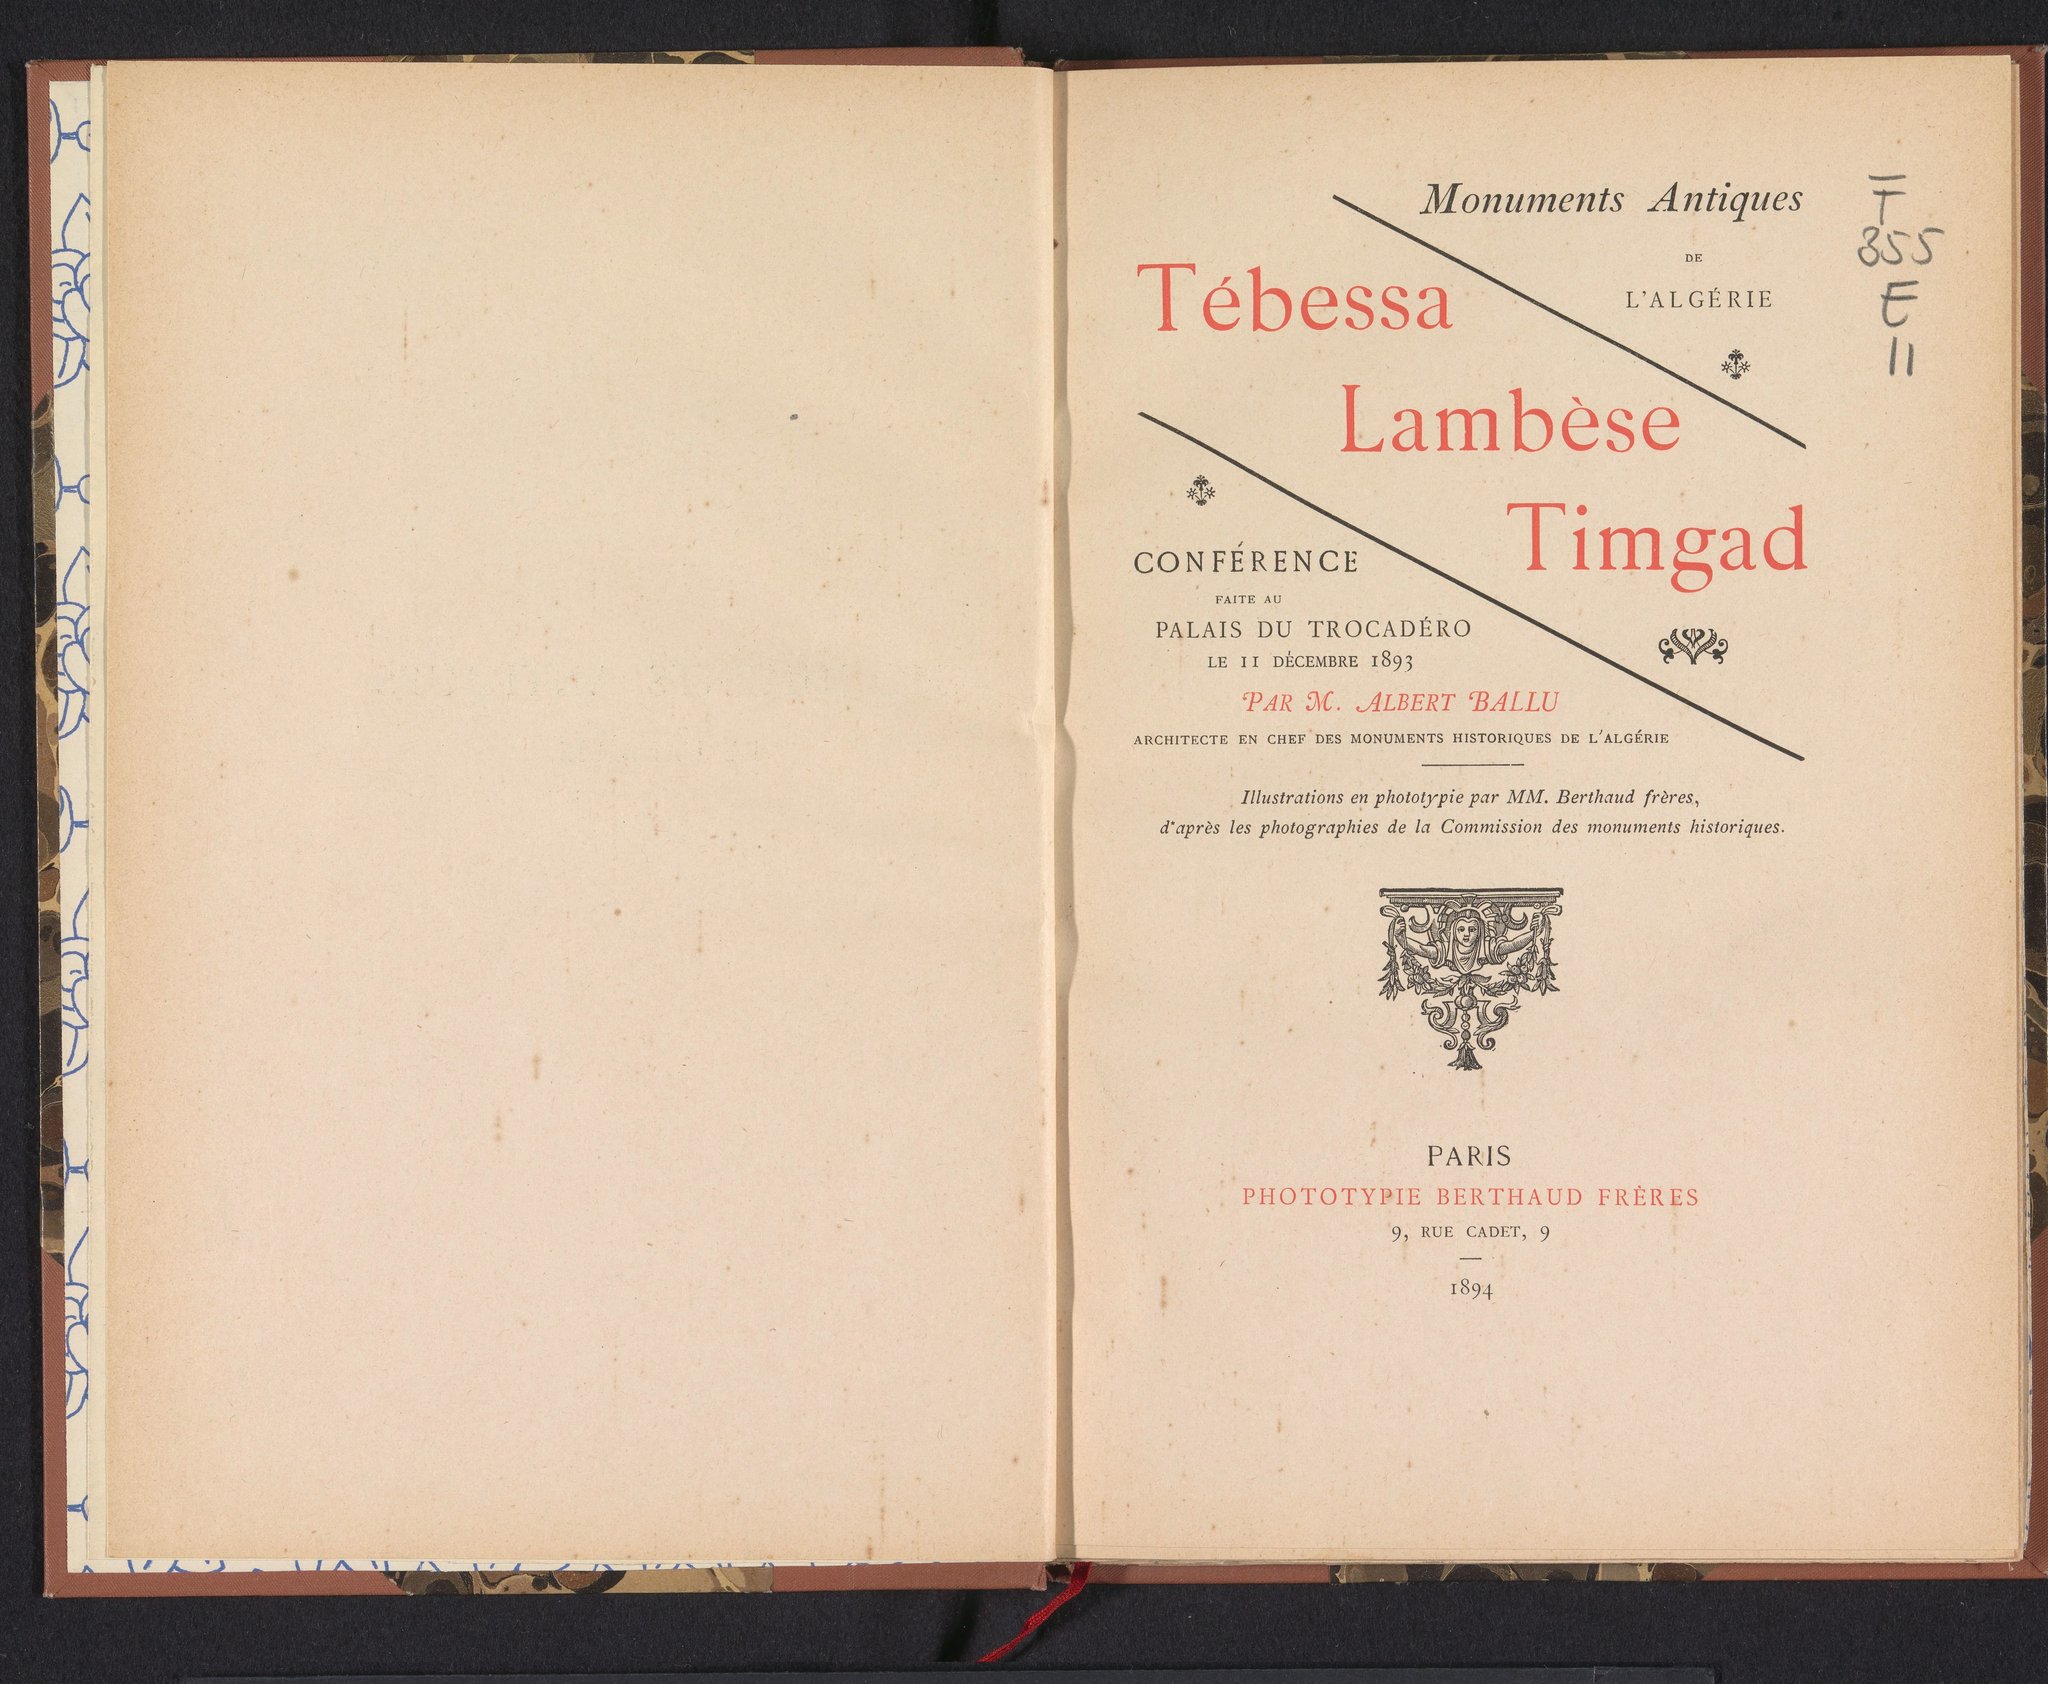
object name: book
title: Monuments antiques de l'Algérie : Tébessa, Lambèse, Timgard : conférence faite au Palais du Trocadéro le 11 Décembre 1893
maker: albert ballu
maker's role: architect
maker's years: 1849-1930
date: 1894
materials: cardboard, paper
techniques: photograph, decorated paper, marbling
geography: paris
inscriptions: name: ‘Gabriel Baugnies’